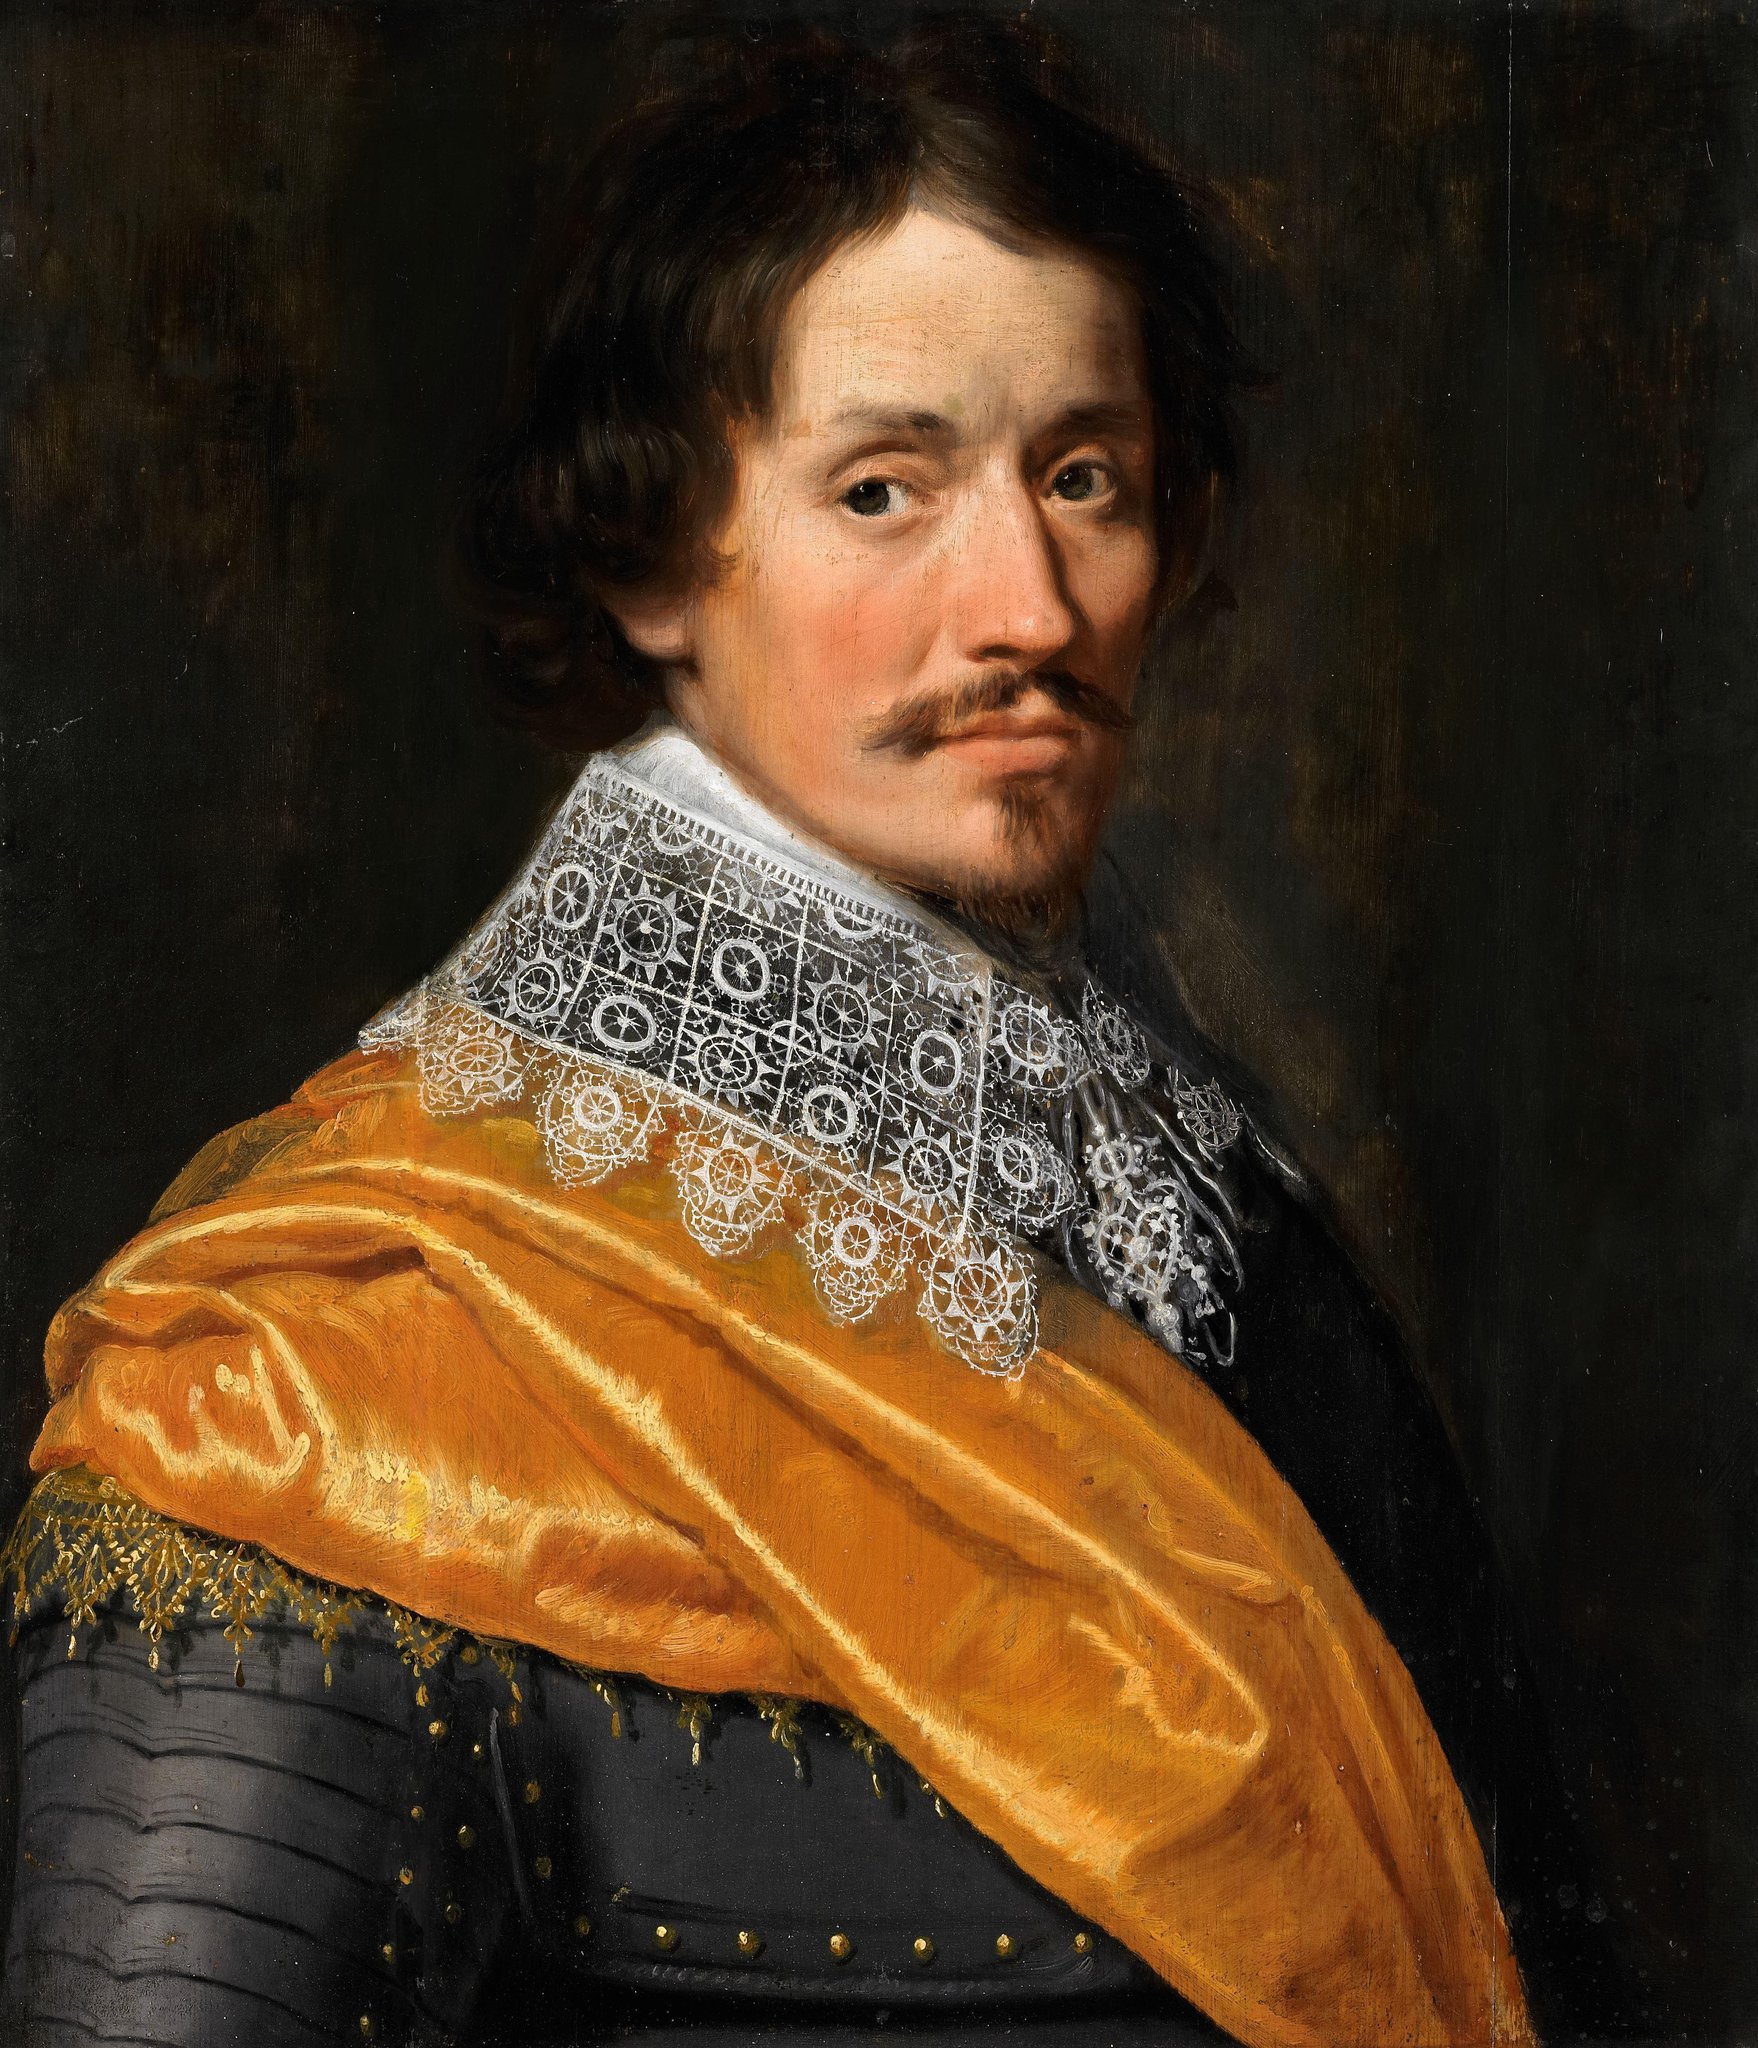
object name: painting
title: Portrait of an Officer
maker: wybrand de geest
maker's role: draughtsman, painter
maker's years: 1592-1665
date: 1625-1635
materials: oil, panel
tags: ranks (in the army, navy, air force), historical persons not known by name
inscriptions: inscription, on the reverse: ‘Deze twee Portretten zijnde de Graven van / Echmont en Hooren komen van wegens J.L. Trip / en Vrouwe A.W. Trip geb van Limburg-stirum / zijnde oorspronkelijk uit het huis van de Graven / van Limburg Stirum. Verzonden van Breda na Hagen aan het / Nationaal Cabinets den [...] juni 1805’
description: Portret van een officier. Buste naar rechts, met een sjerp en kanten kraag over het borstharnas. Zie ook het portret door Van Ravesteyn: SK-A-4191.